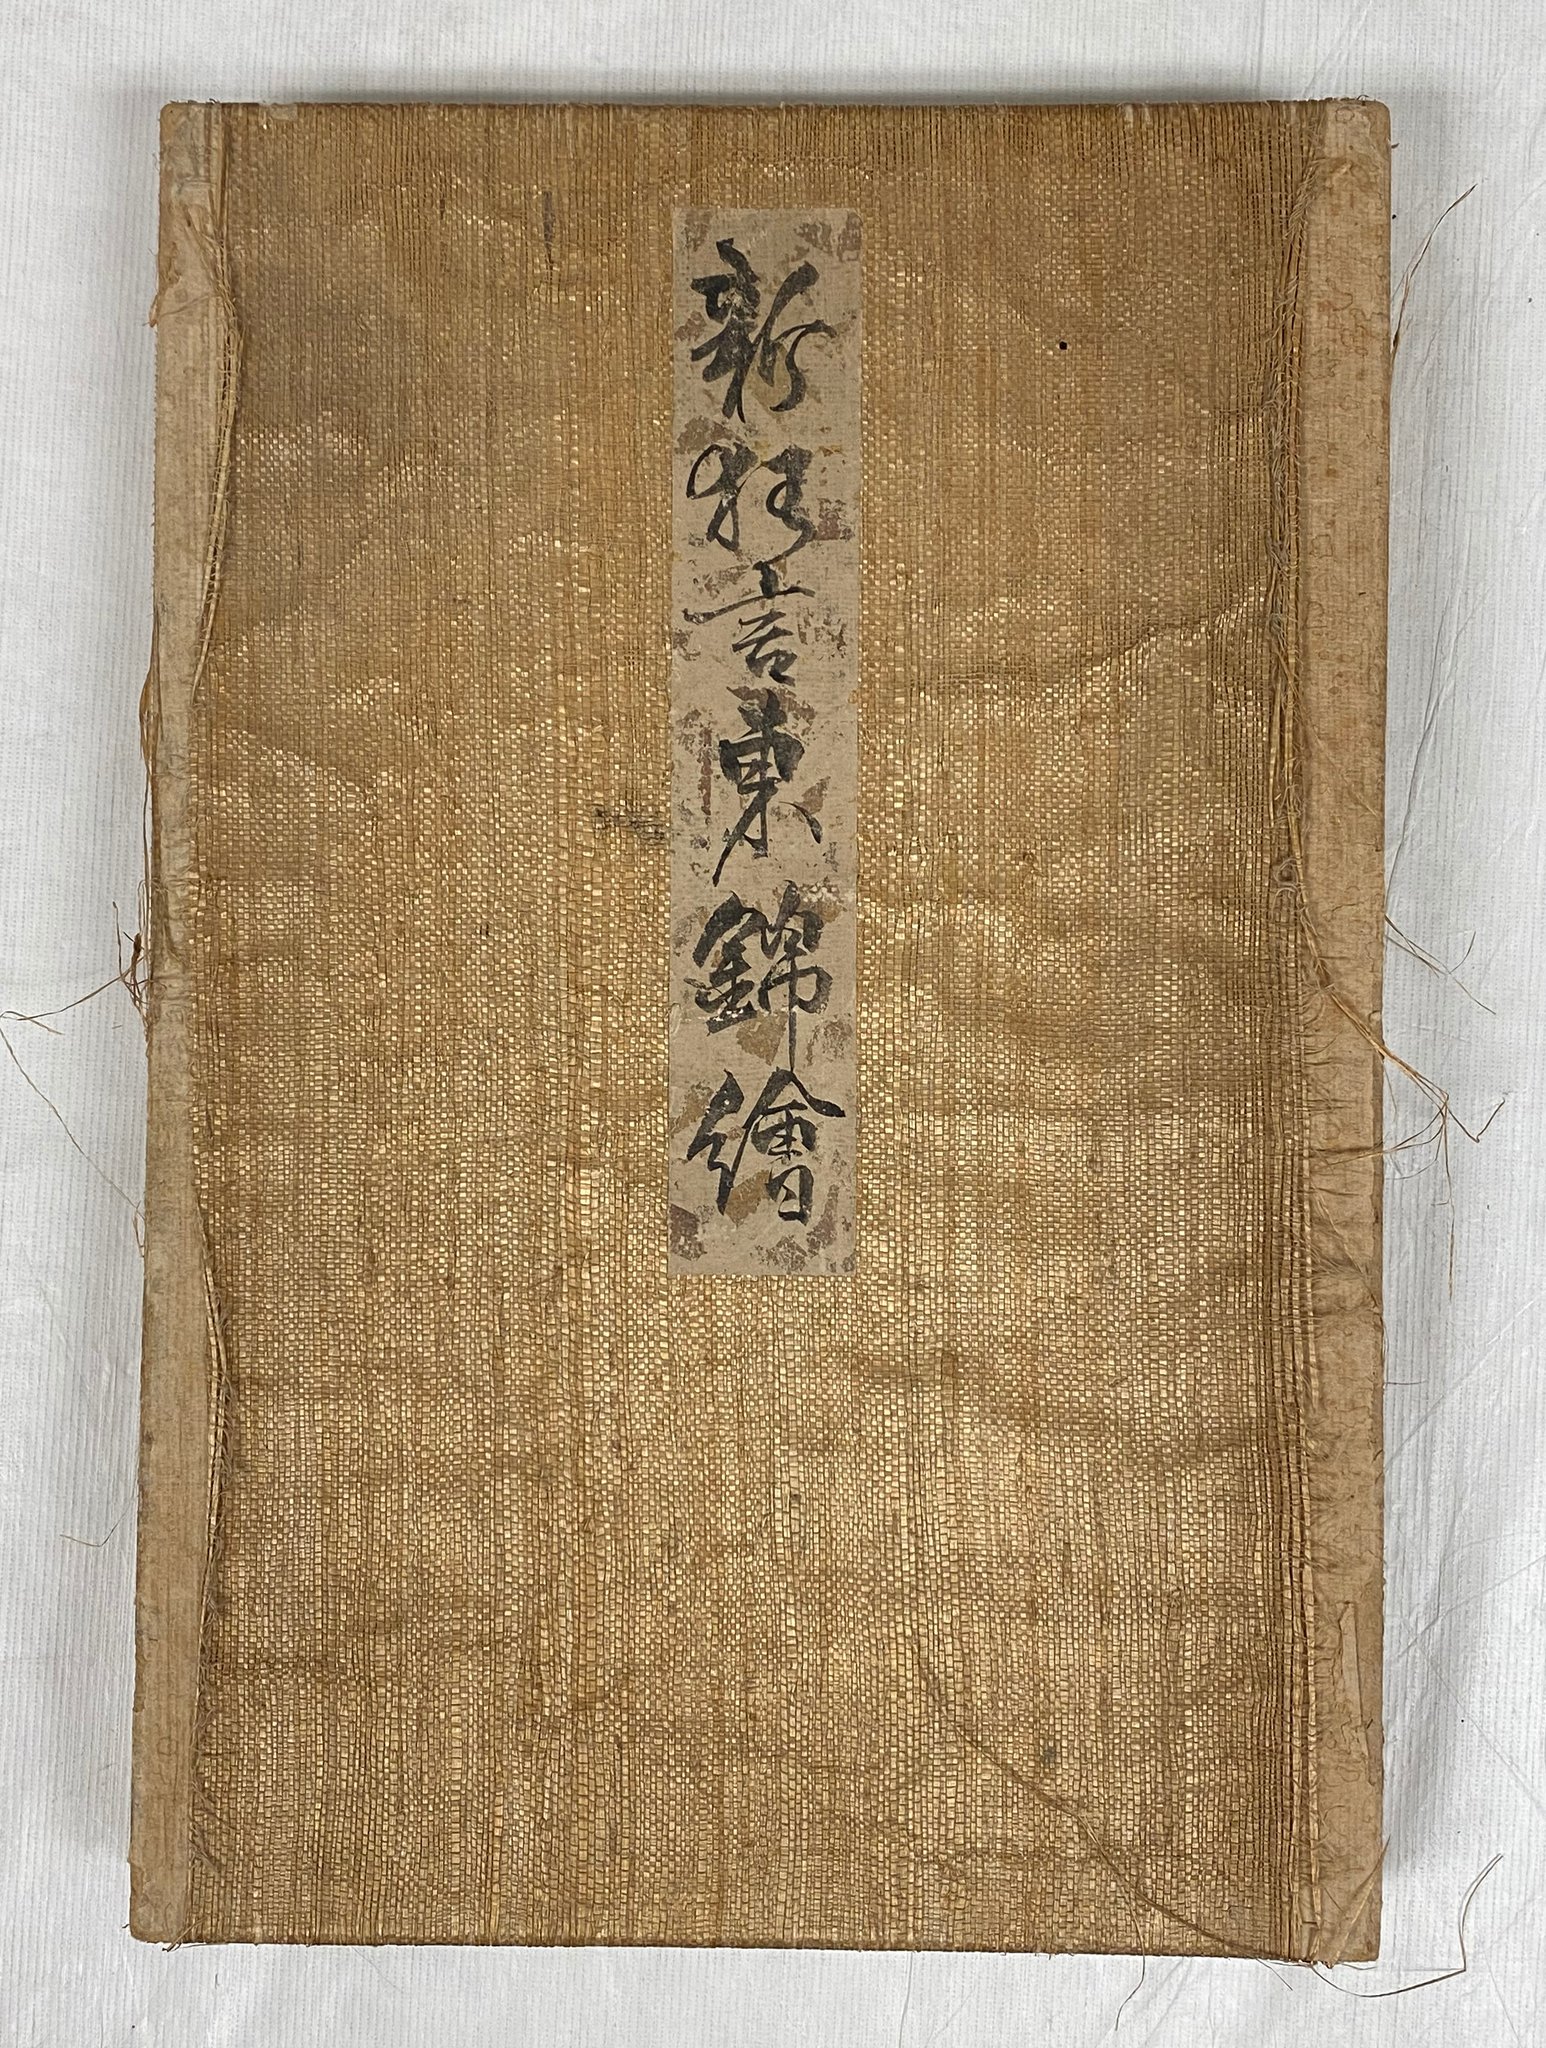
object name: illustrated book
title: Illustrations of New Kabuki Kyogen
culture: japanese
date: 1897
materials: ink, paper